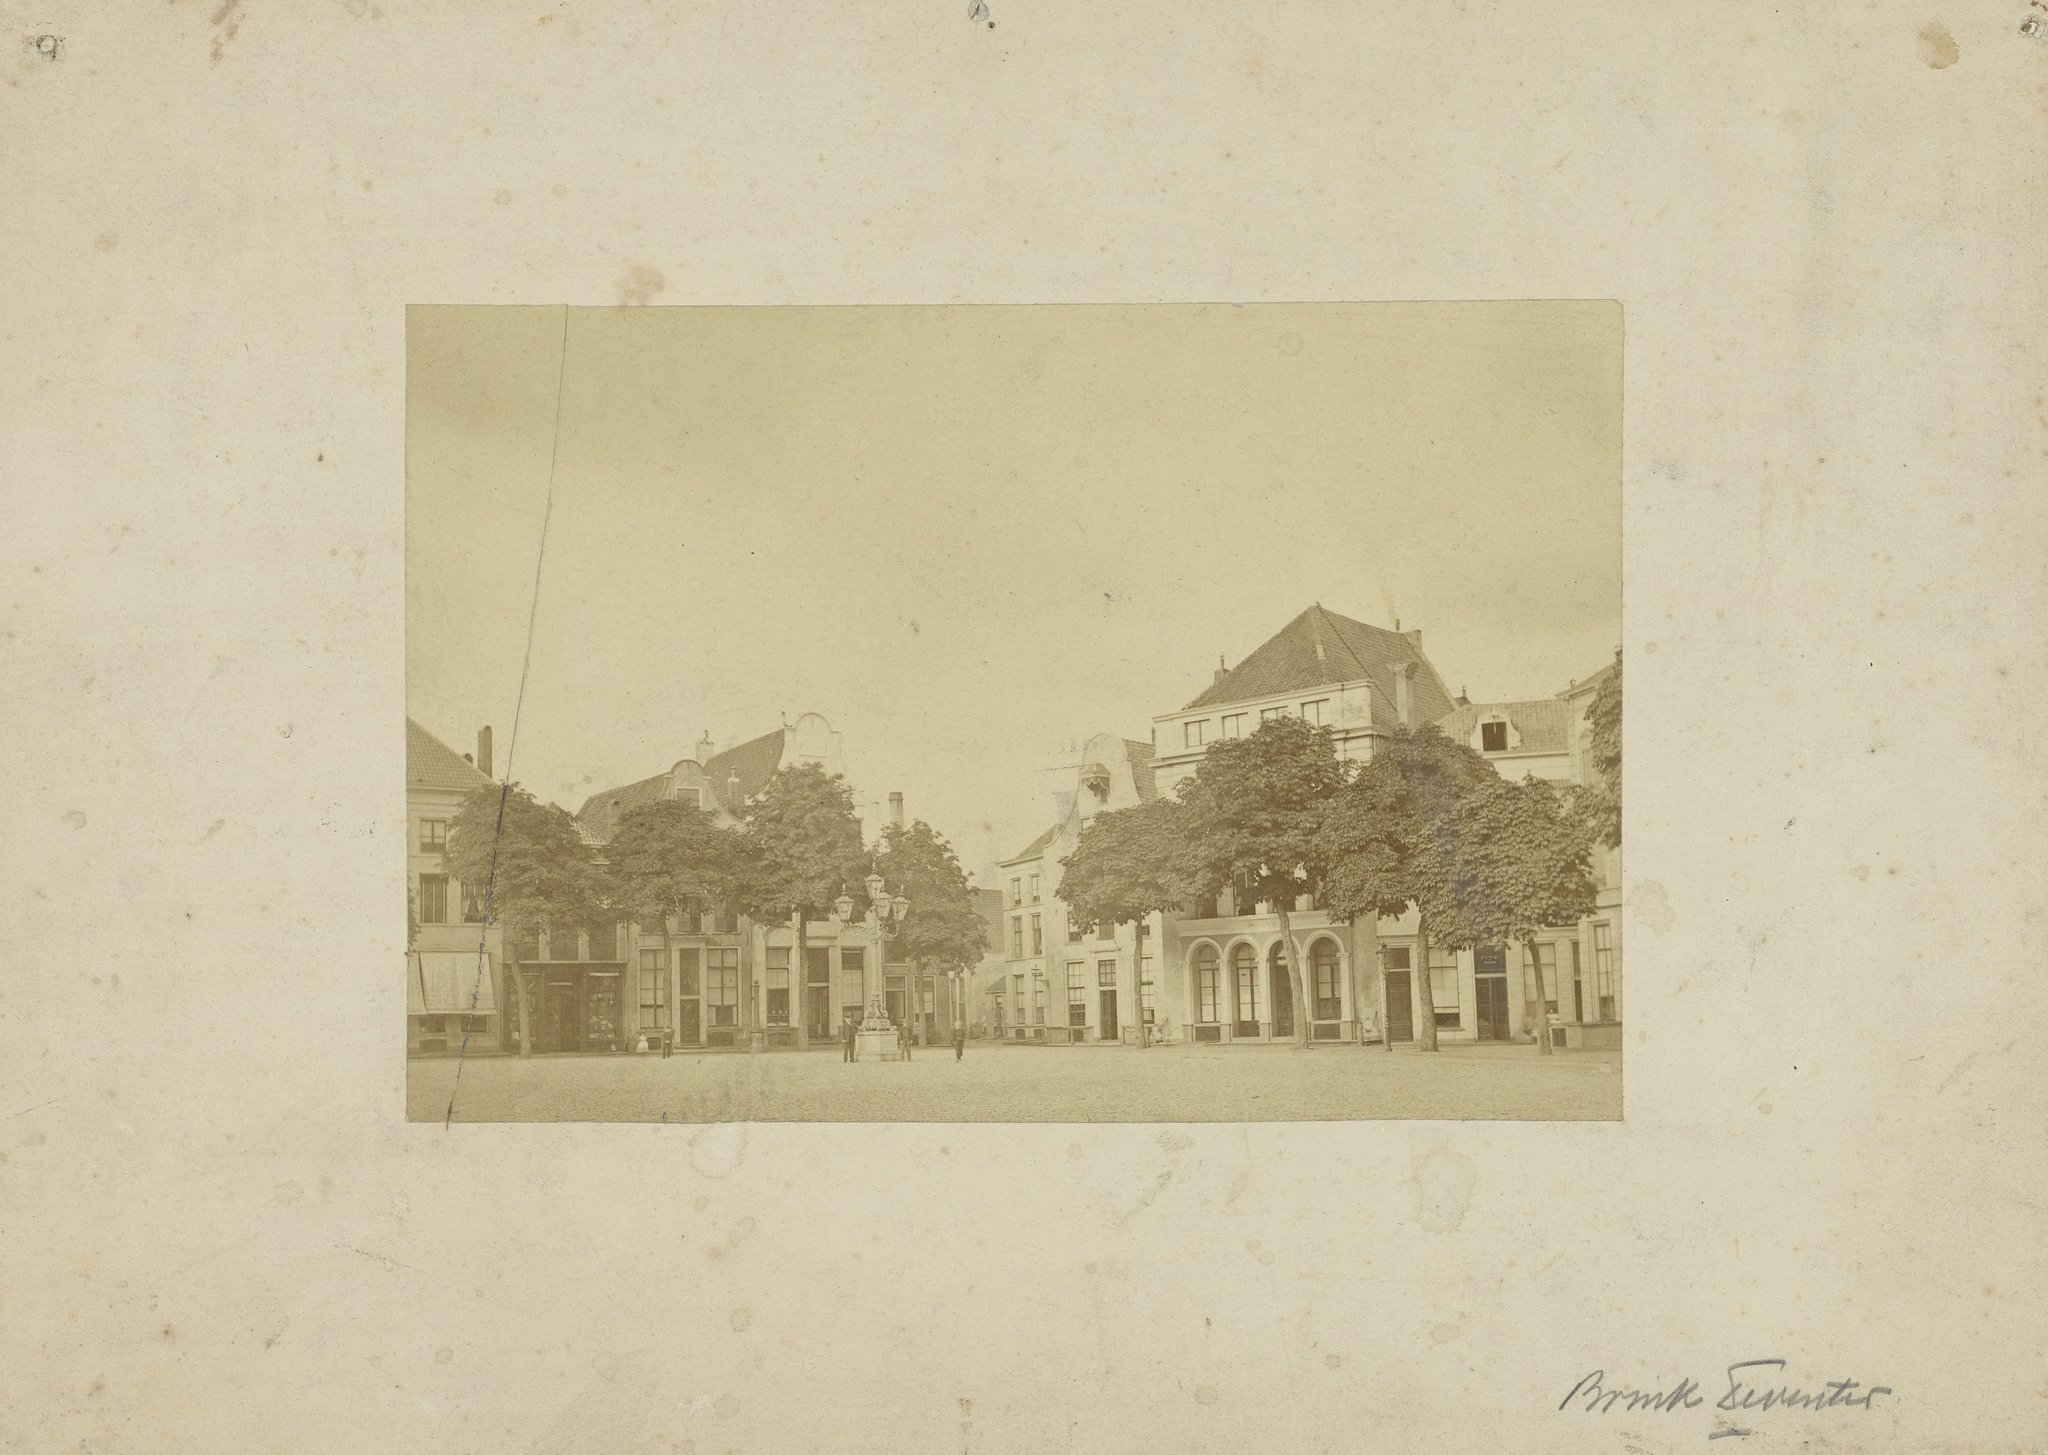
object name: photograph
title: De Brink in Deventer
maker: Anonymous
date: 1850-1880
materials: cardboard, photographic support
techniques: albumen print